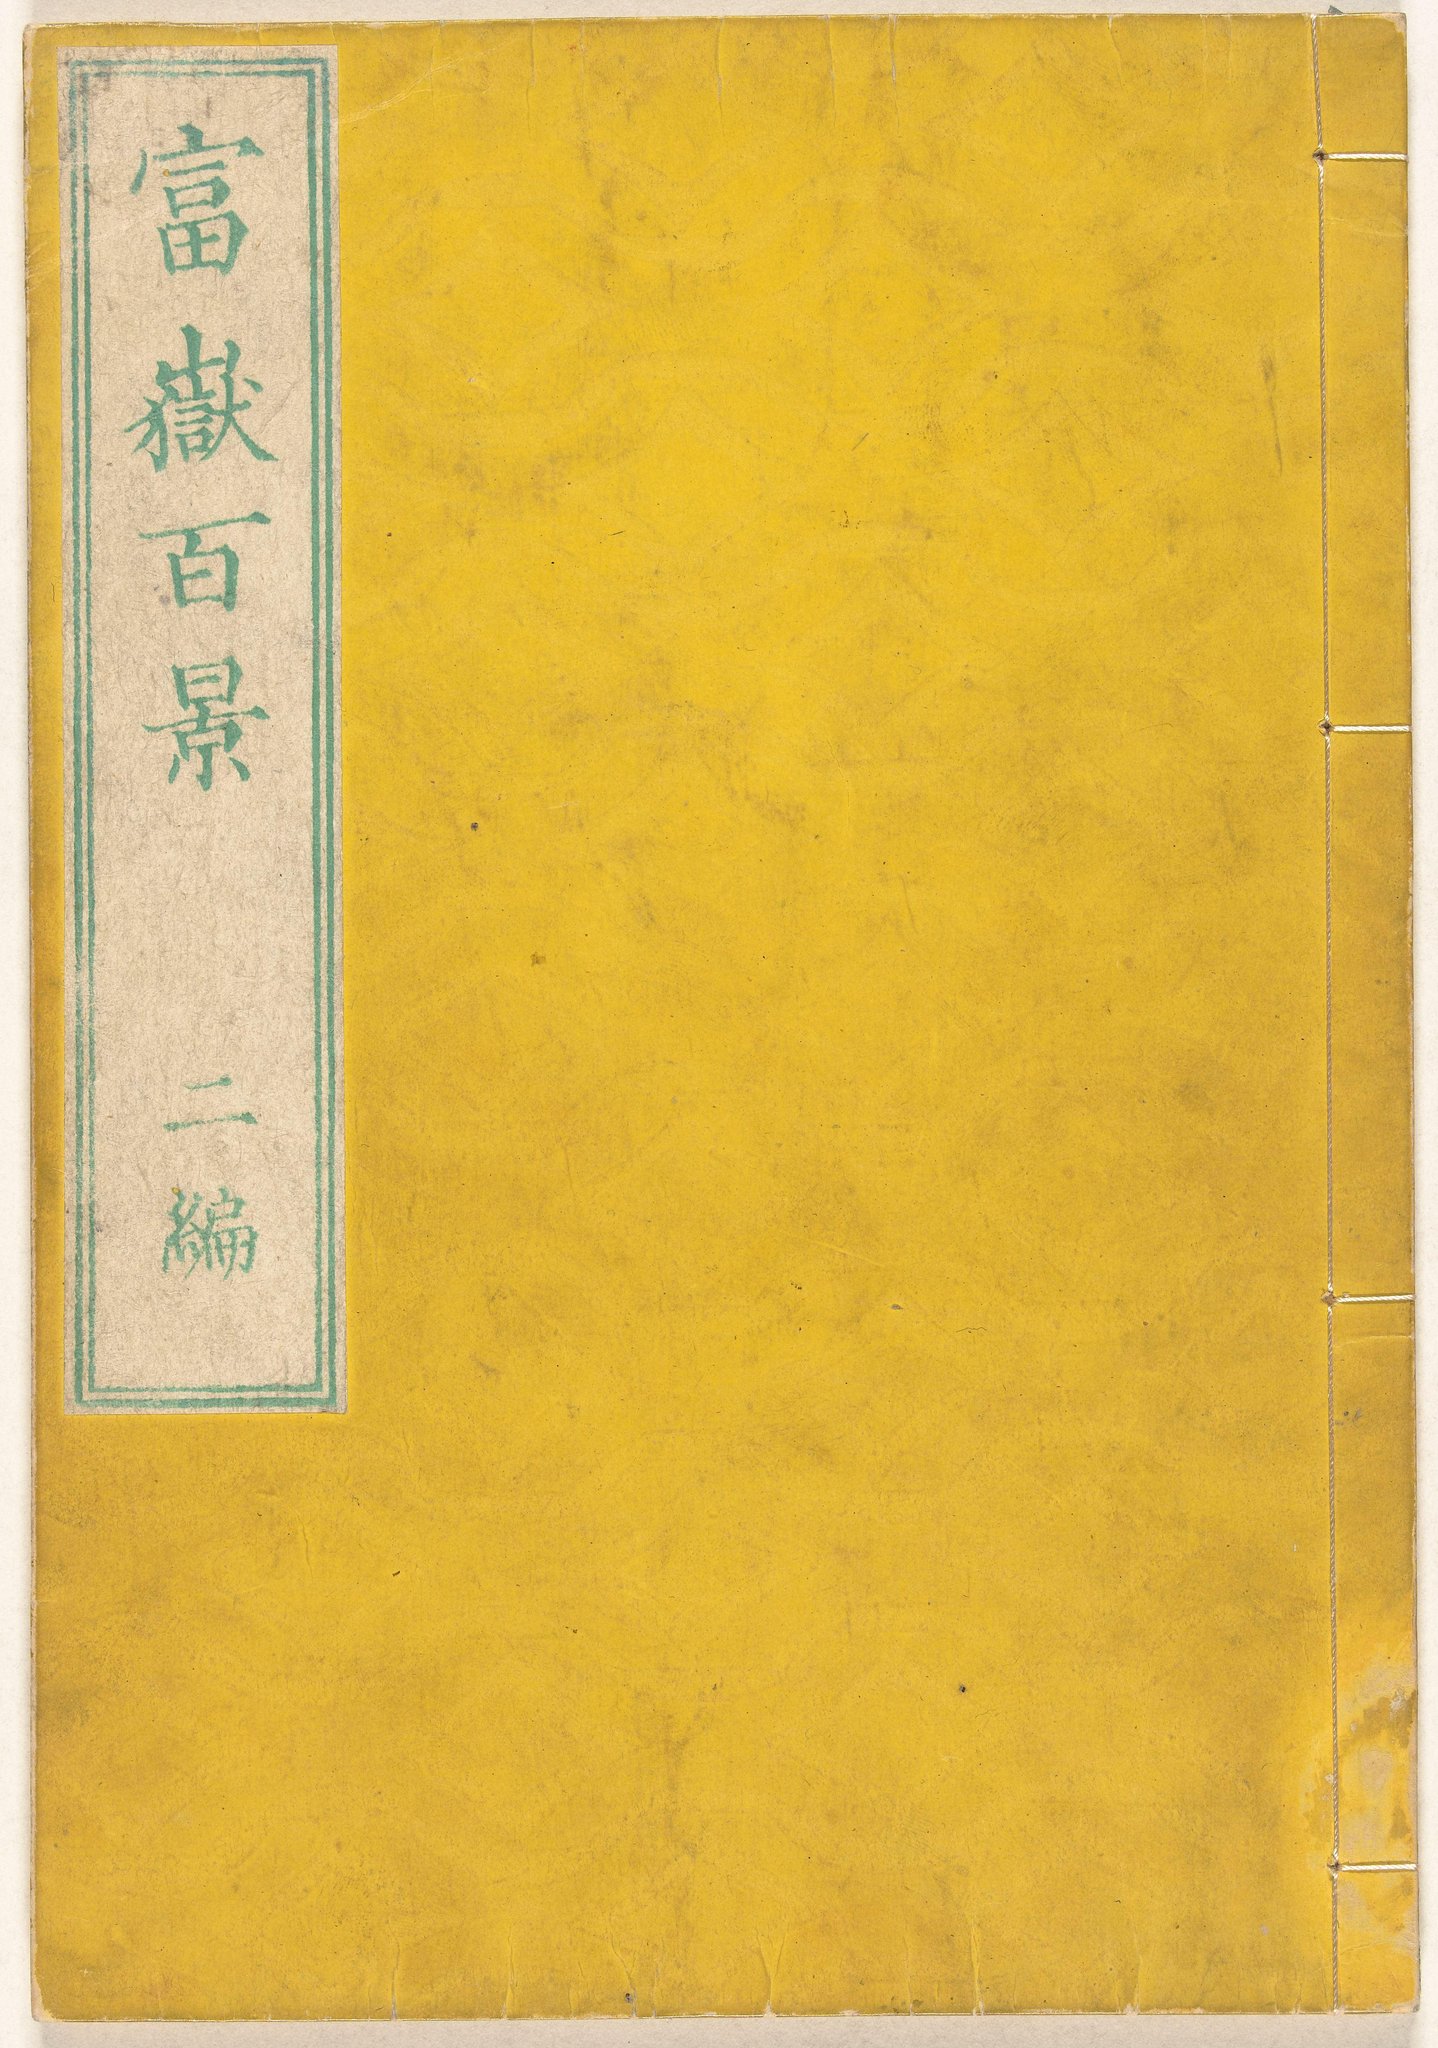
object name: book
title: Honderd gezichten op de berg Fuji - deel twee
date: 1875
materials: paper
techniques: woodcut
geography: tokyo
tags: fuji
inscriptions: collector's mark: ‘Rijksschool voor kunstnijverheid’ Lugt 3937, collector's mark: Lugt 2228